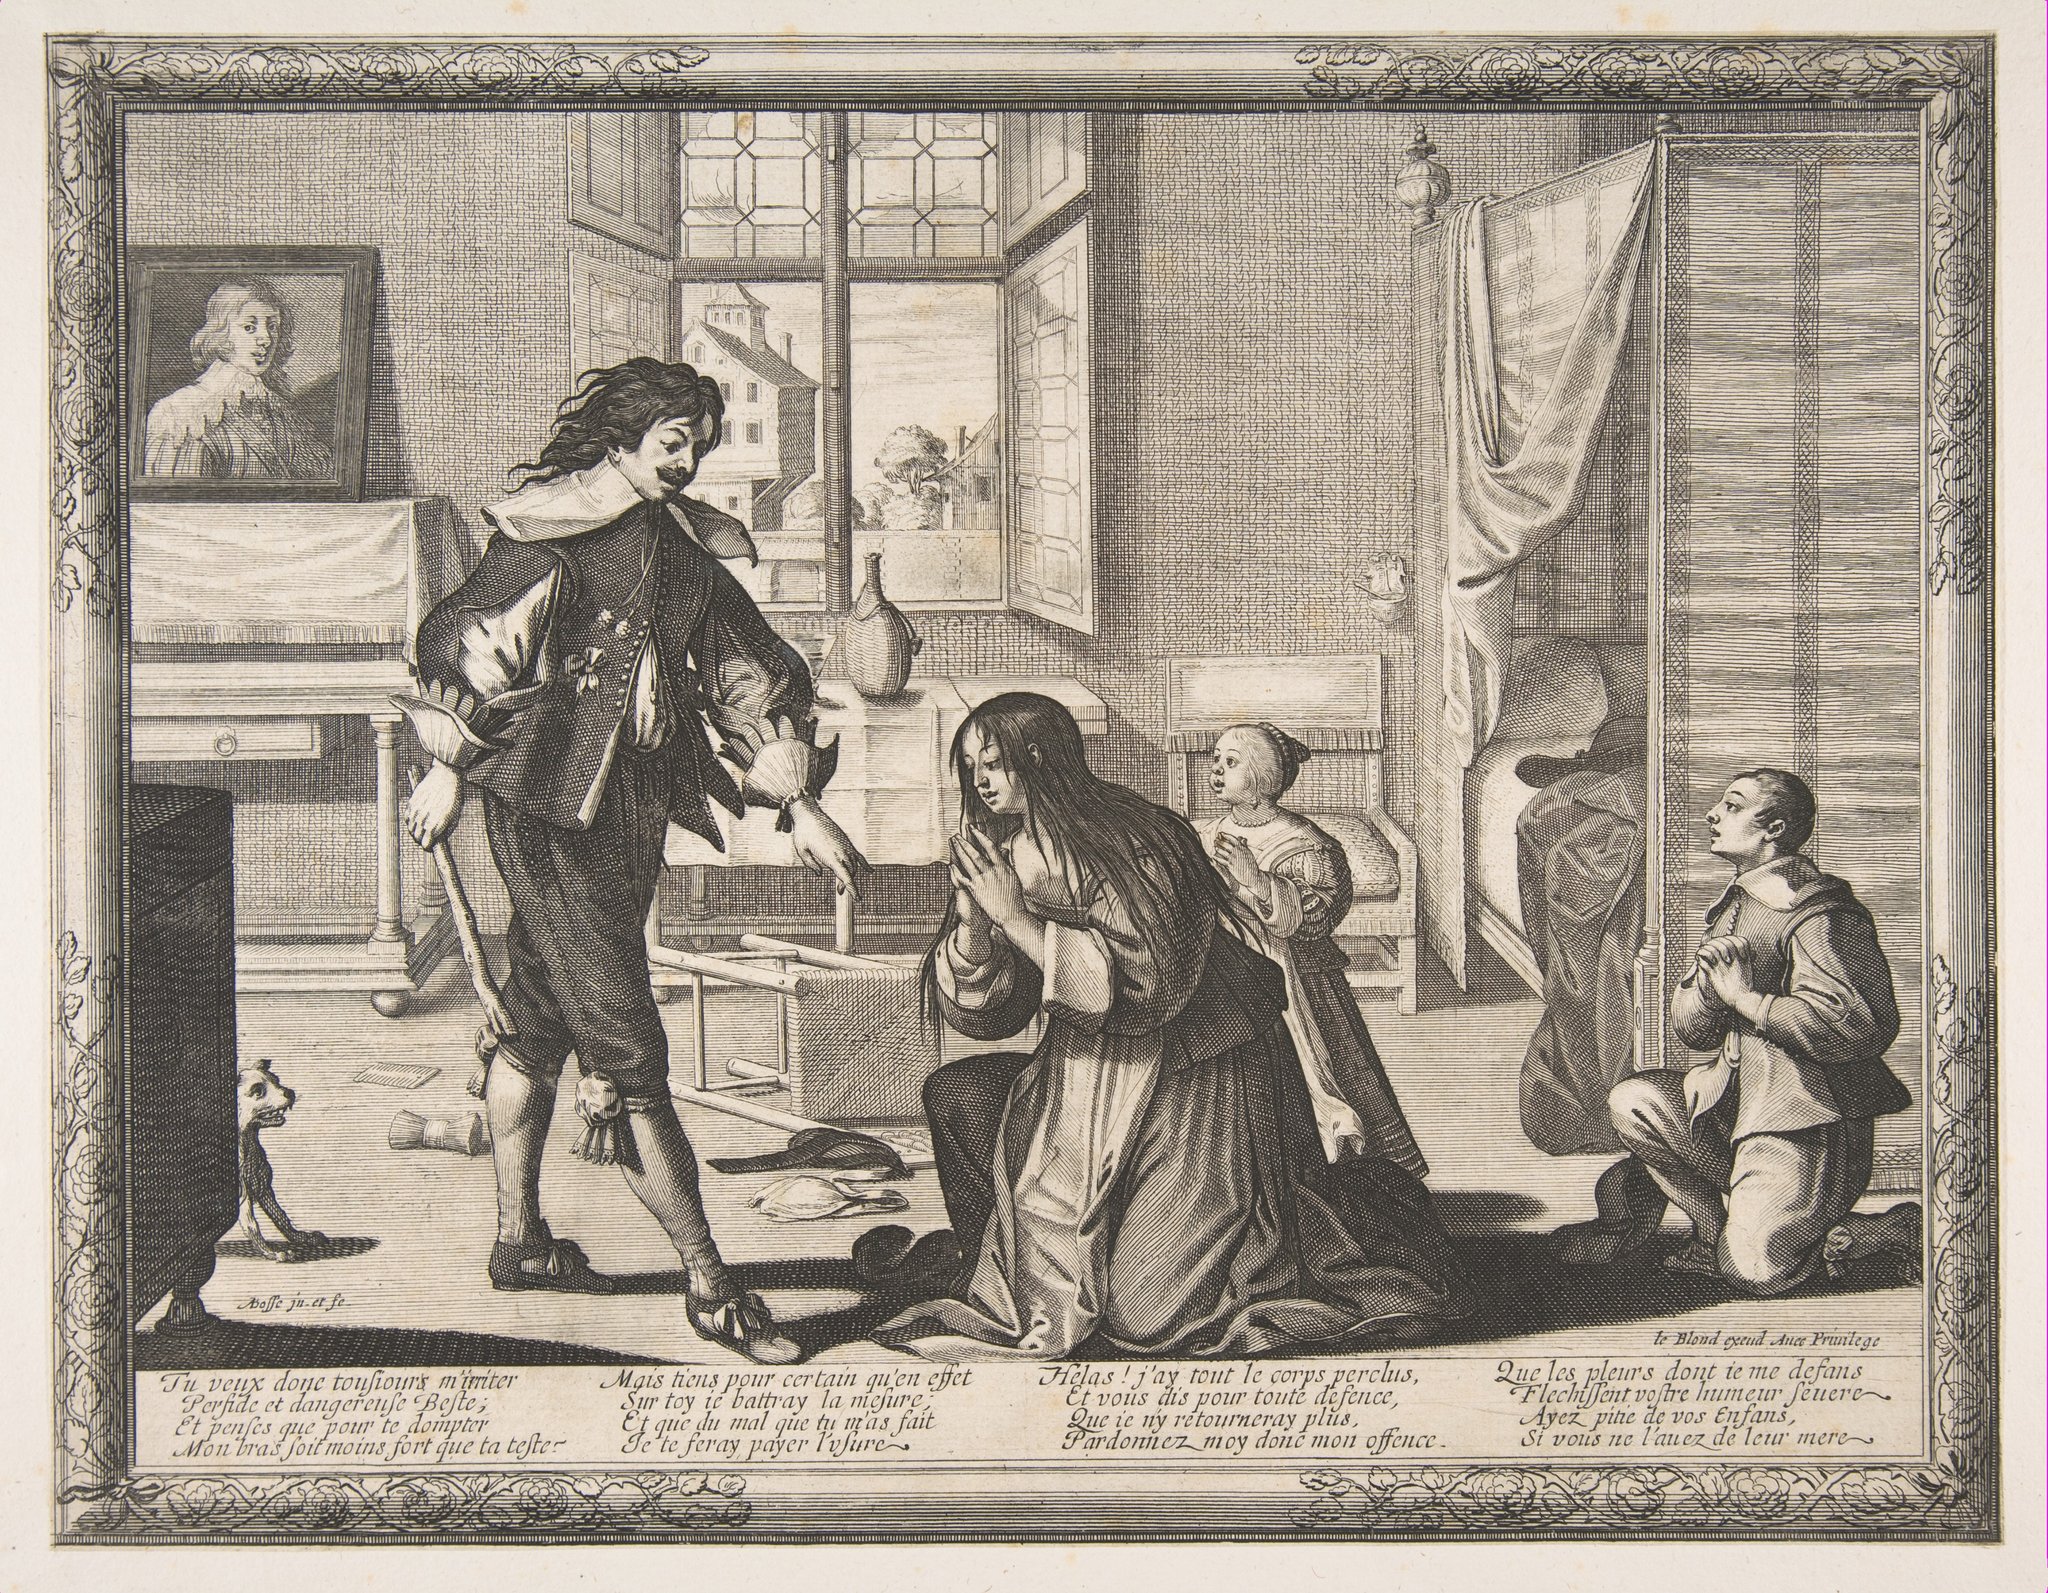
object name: print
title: The Wife-Beater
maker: abraham bosse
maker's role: artist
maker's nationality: french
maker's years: 1602-1676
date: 1633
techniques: engraving, etching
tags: girls,men,women